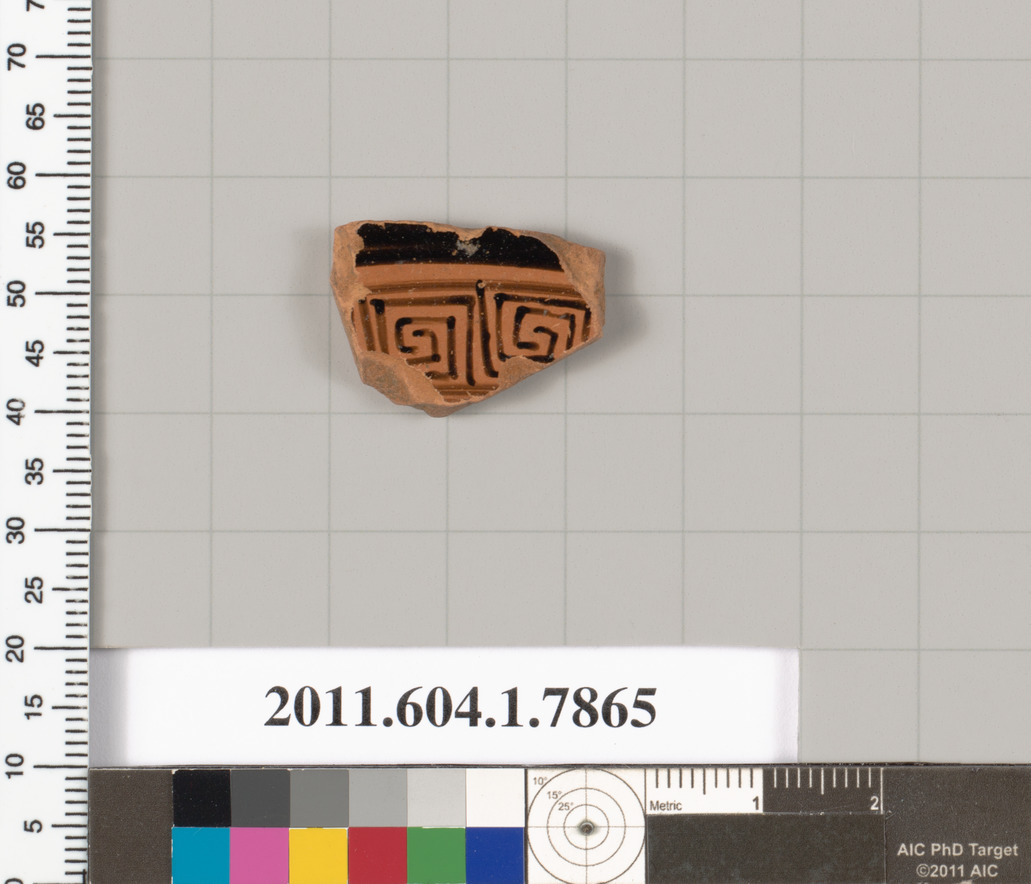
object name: kylix fragment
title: Terracotta fragment of a kylix (drinking cup)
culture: greek, attic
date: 440-420 BCE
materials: terracotta